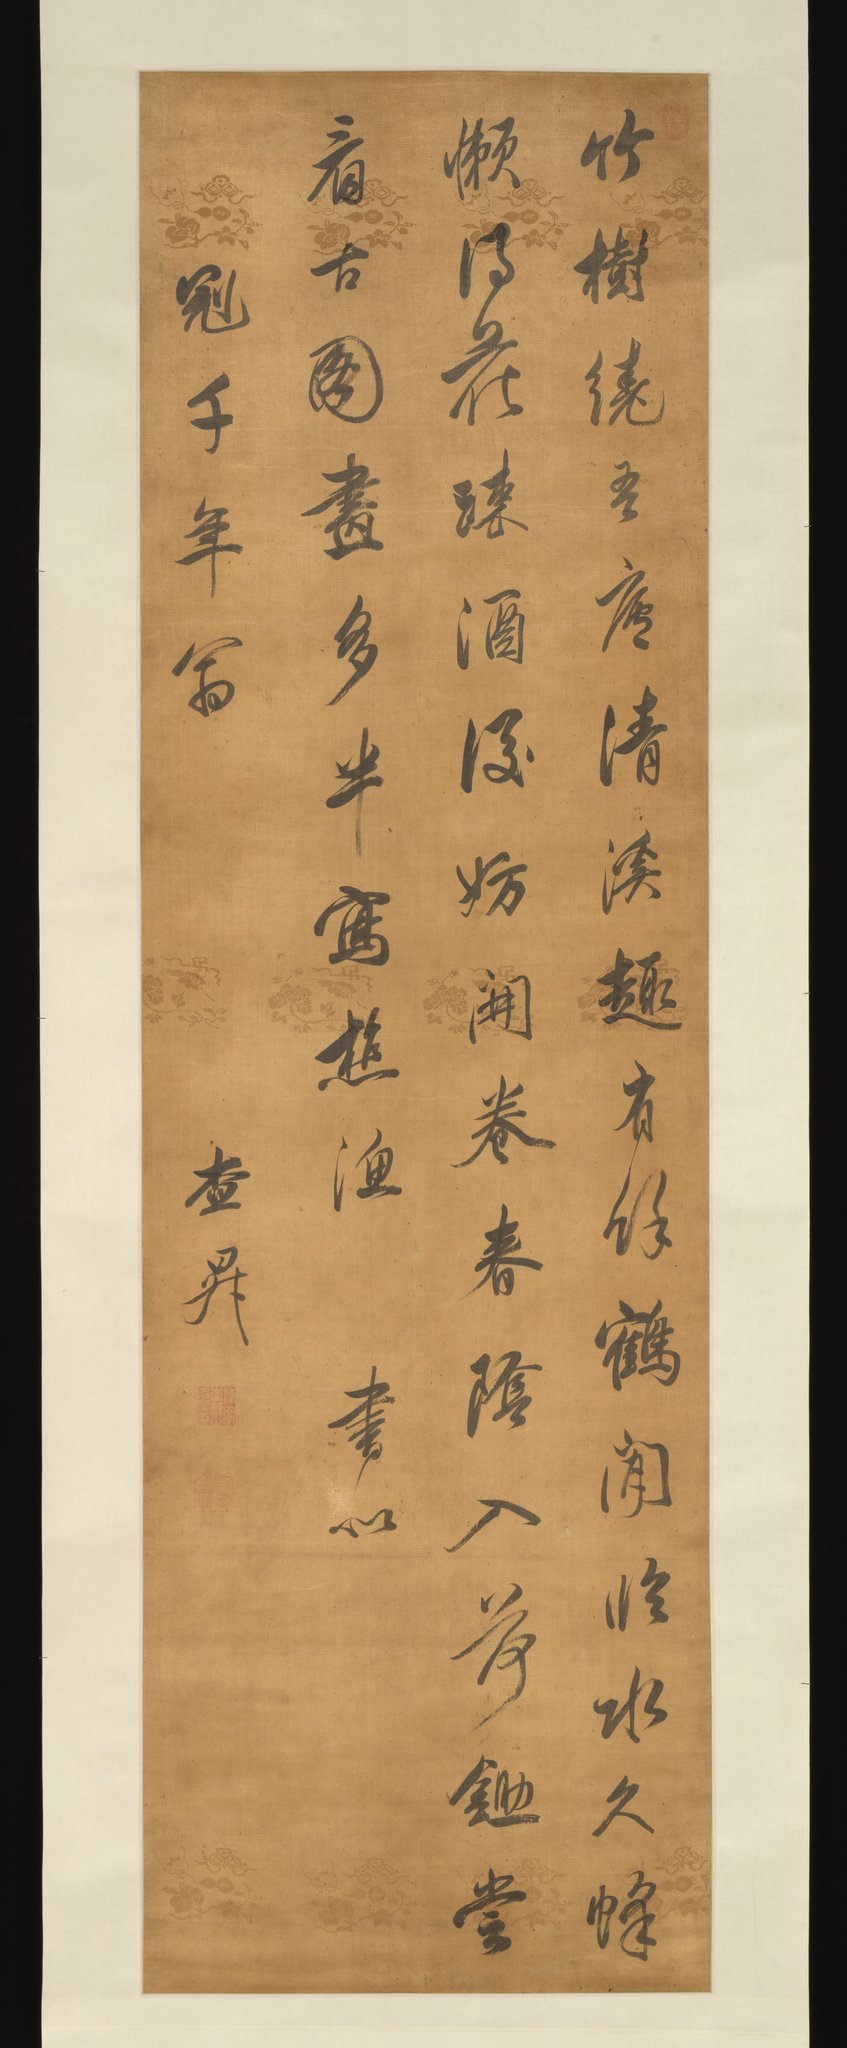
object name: hanging scroll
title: Poem on reclusion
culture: chinese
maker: zha sheng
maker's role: calligrapher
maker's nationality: chinese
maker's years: 1650-1707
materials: ink, silk